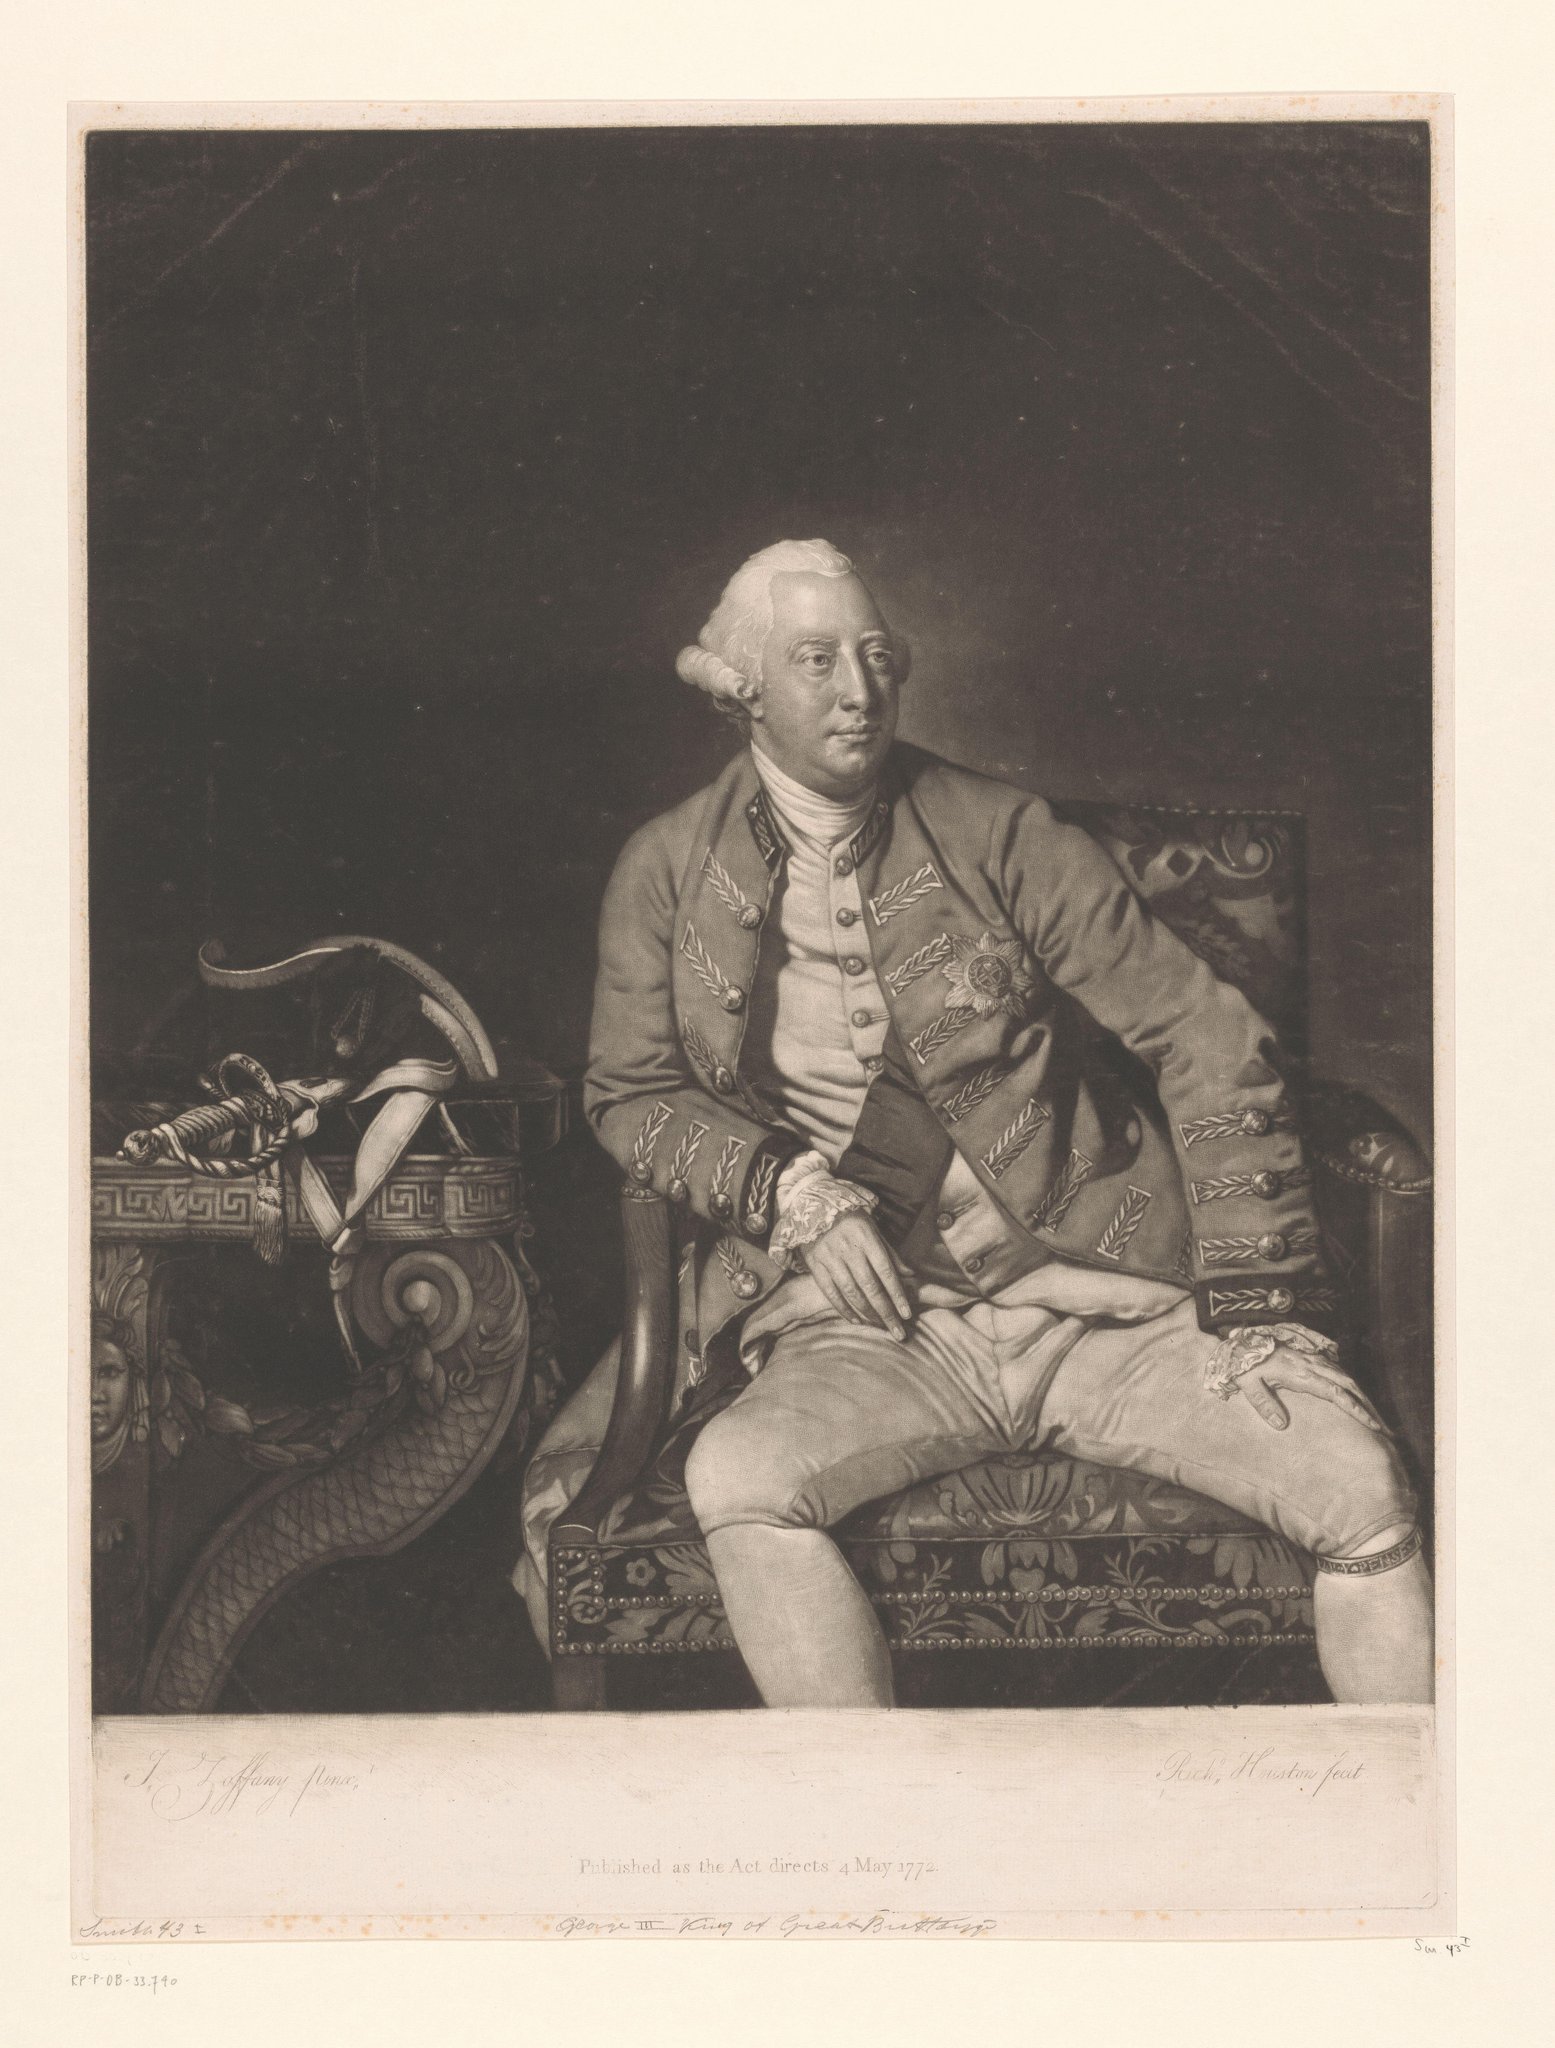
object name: print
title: Portret van George III, koning van het Verenigd Koninkrijk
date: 1772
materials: paper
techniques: mezzotint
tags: london, george iii (koning van het verenigd koninkrijk), historical persons, king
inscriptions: collector's mark: Lugt 240